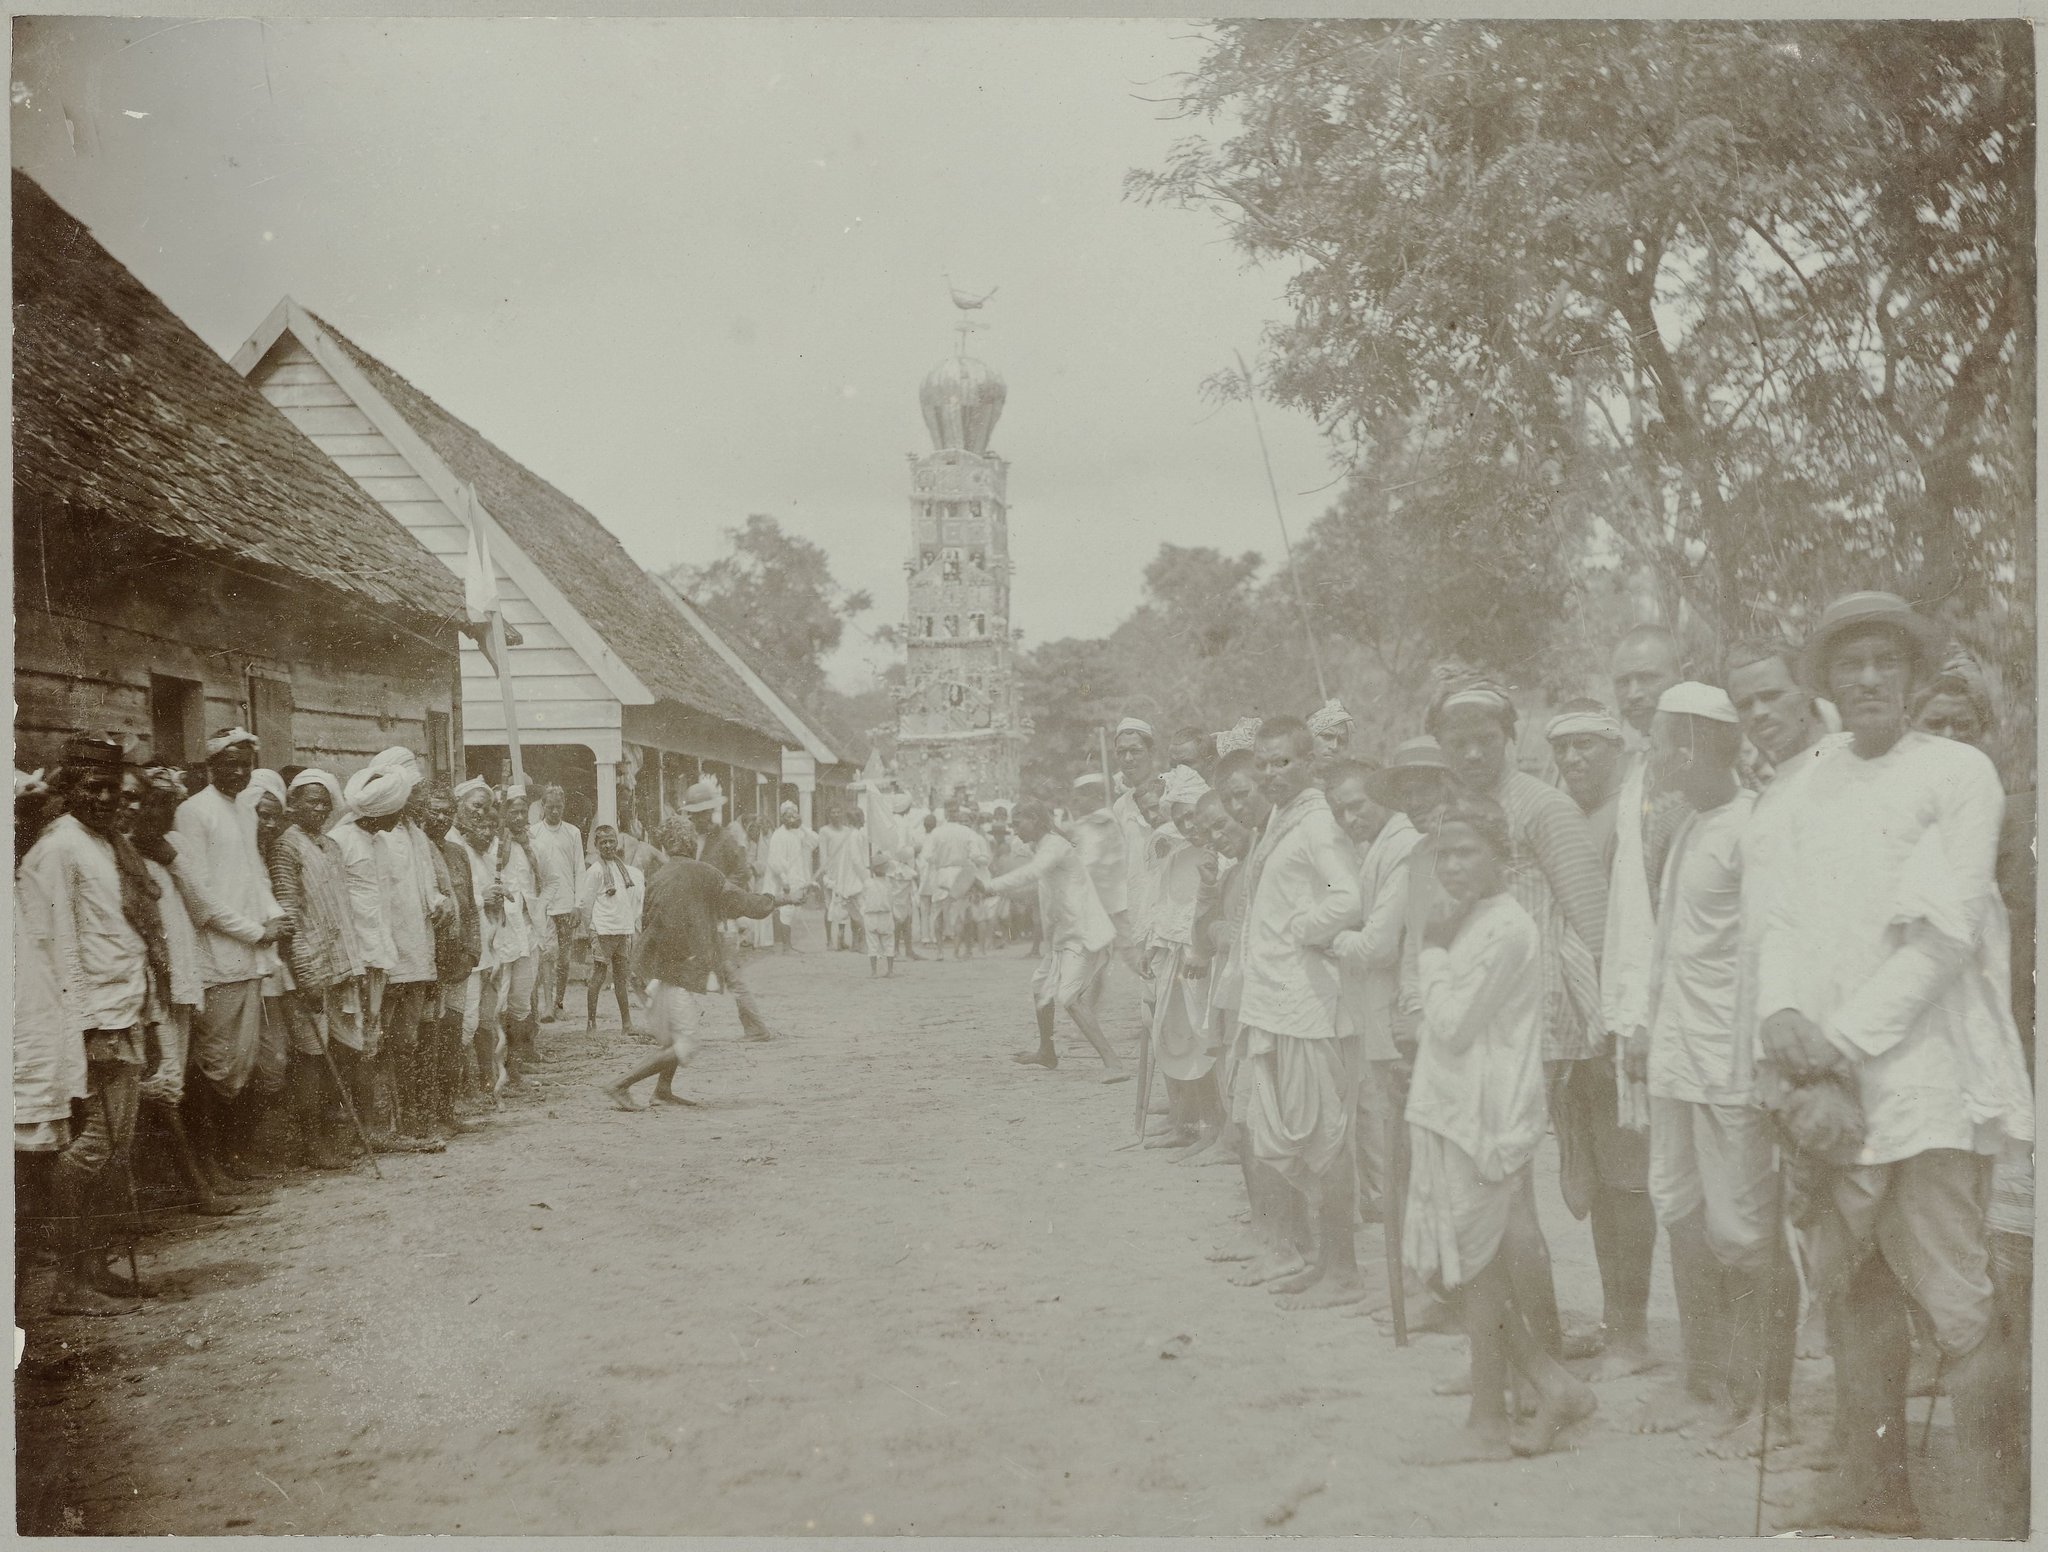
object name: photograph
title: Tadja-feest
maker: julius muller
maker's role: official, politician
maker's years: 1846-1902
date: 1880-1900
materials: photographic support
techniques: collodion silver print, gelatin silver print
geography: suriname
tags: suriname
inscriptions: inscription: ‘Tadja-feest, cliché Muller.’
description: De viering van het Tadja feest of tajiya-festival door de Hindostaanse moslims onder de Brits-Indische immigranten. Onderdeel van het fotoalbum Souvenir de Voyage (deel 3), over het leven van de familie Dooyer in en rond de plantage Ma Retraite in Suriname in de jaren 1906-1913.